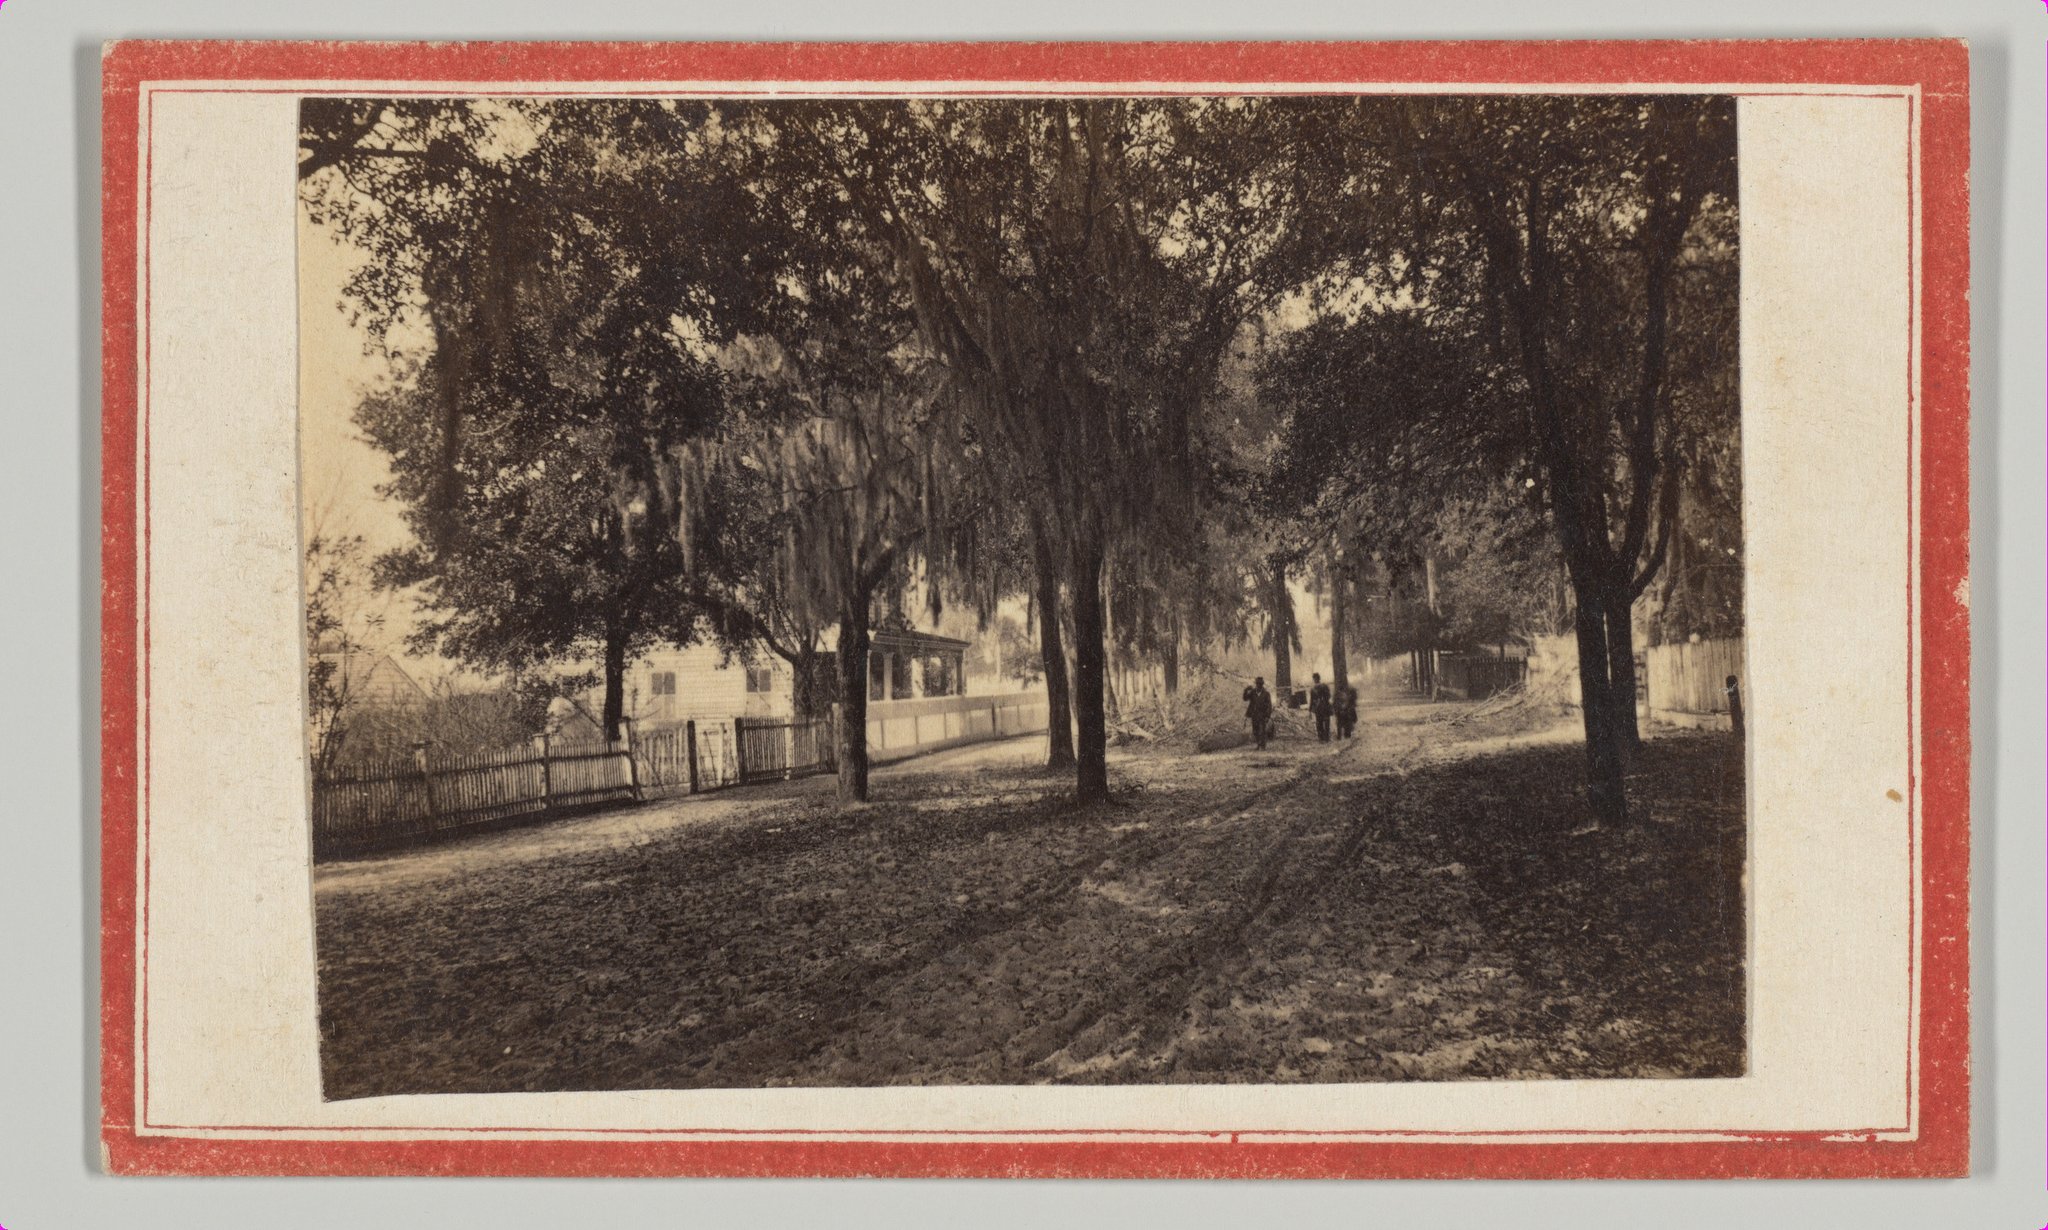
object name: carte de visite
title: [Street Scene with Soldiers, Jacksonville, Florida]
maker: edward w. sinclair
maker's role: artist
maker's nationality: american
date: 1864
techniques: albumen silver print, glass negative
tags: american civil war